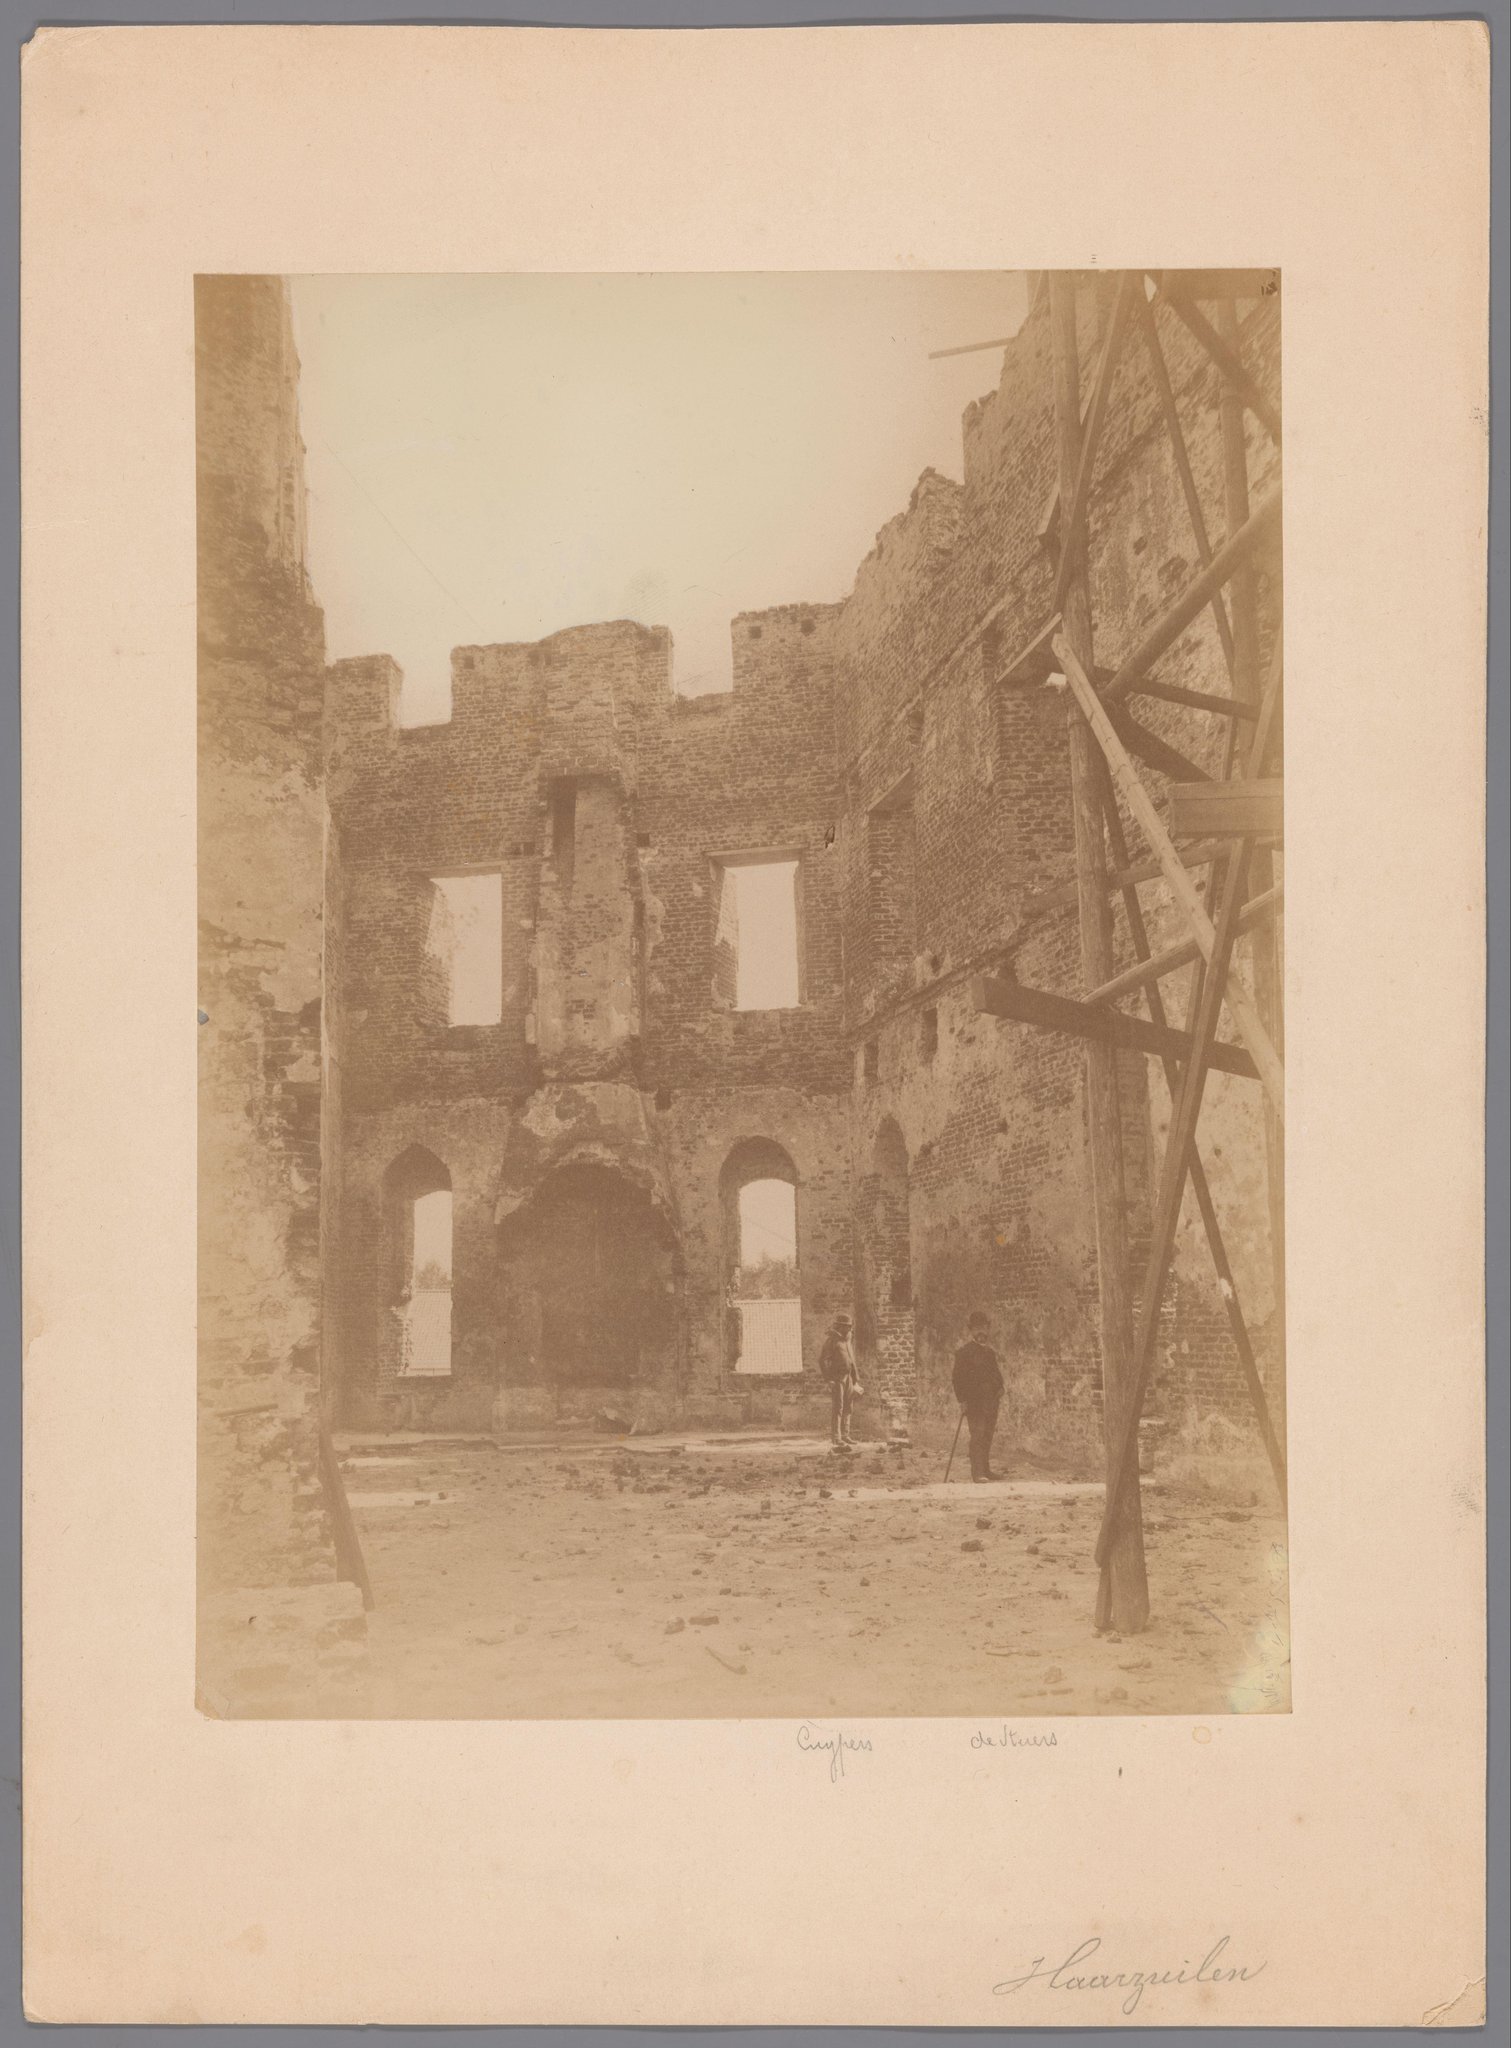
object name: photograph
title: Ruïne van Kasteel de Haar te Haarzuilens, met Pierre Cuypers en Victor de Stuers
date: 1892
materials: cardboard, photographic support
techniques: albumen print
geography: kasteel de haar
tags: the hague, print maker, jonkheer victor eugène louis de stuers, draughtsman, pierre joseph hubert cuypers, ruin of a dwelling, house, castle, etc.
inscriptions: annotation: ‘Ruine van het huis "de haar" / te / Haarzuilen / Na de ontgraving July 1892 / Aangezicht in een der zalen’, annotation: ‘Cuypers de Stuers’